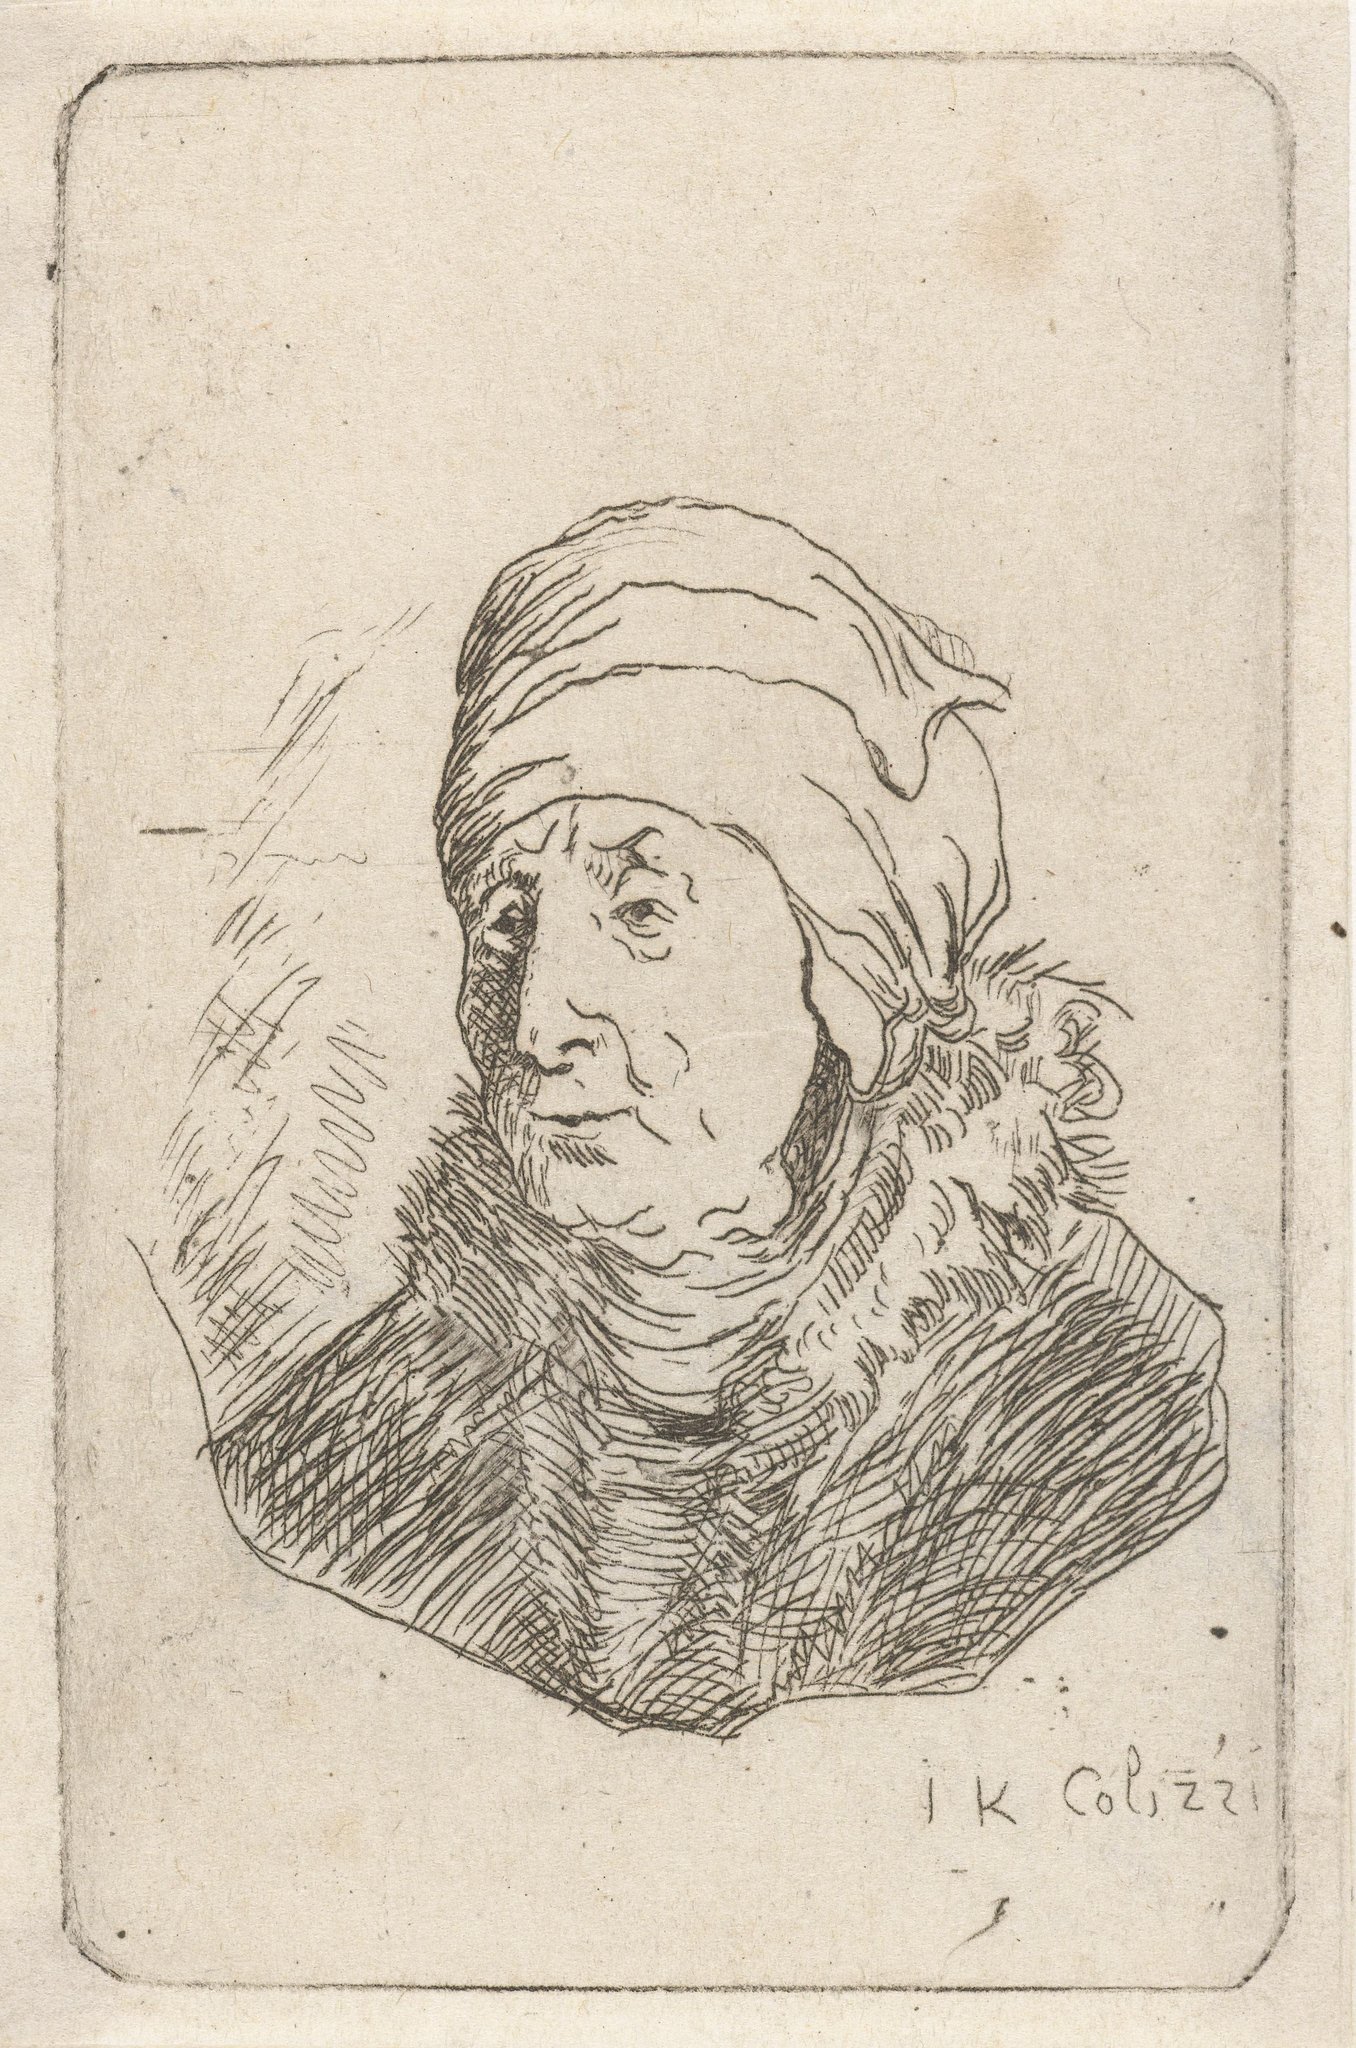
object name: print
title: Portret van een oude vrouw met hoofddoek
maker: johan antoni kauclitz colizzi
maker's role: print maker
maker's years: 1742-1808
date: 1774-1808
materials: paper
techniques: etching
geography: netherlands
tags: anonymous historical person portrayed alone - bb - woman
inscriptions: collector's mark: Lugt 2227